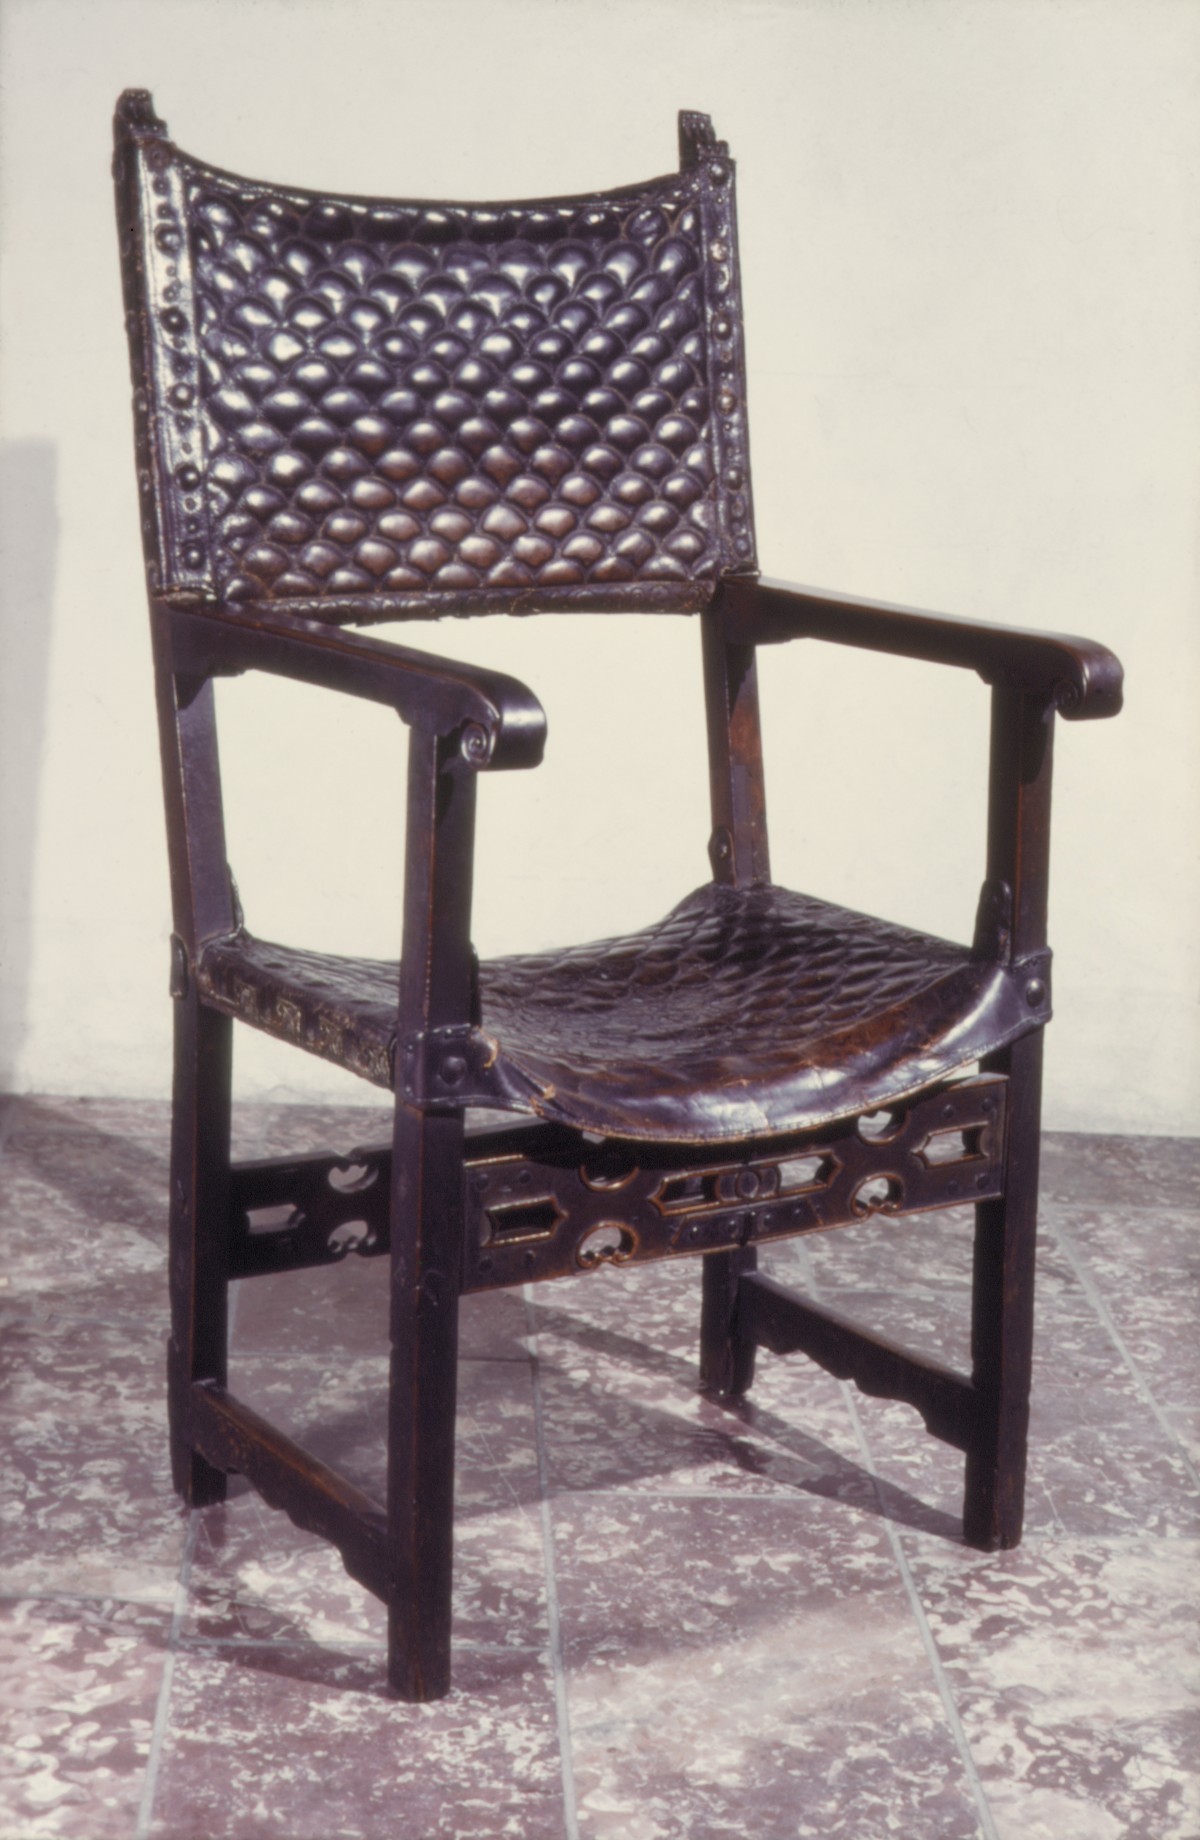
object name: armchair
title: Folding armchair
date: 1501-1600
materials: leather, wood